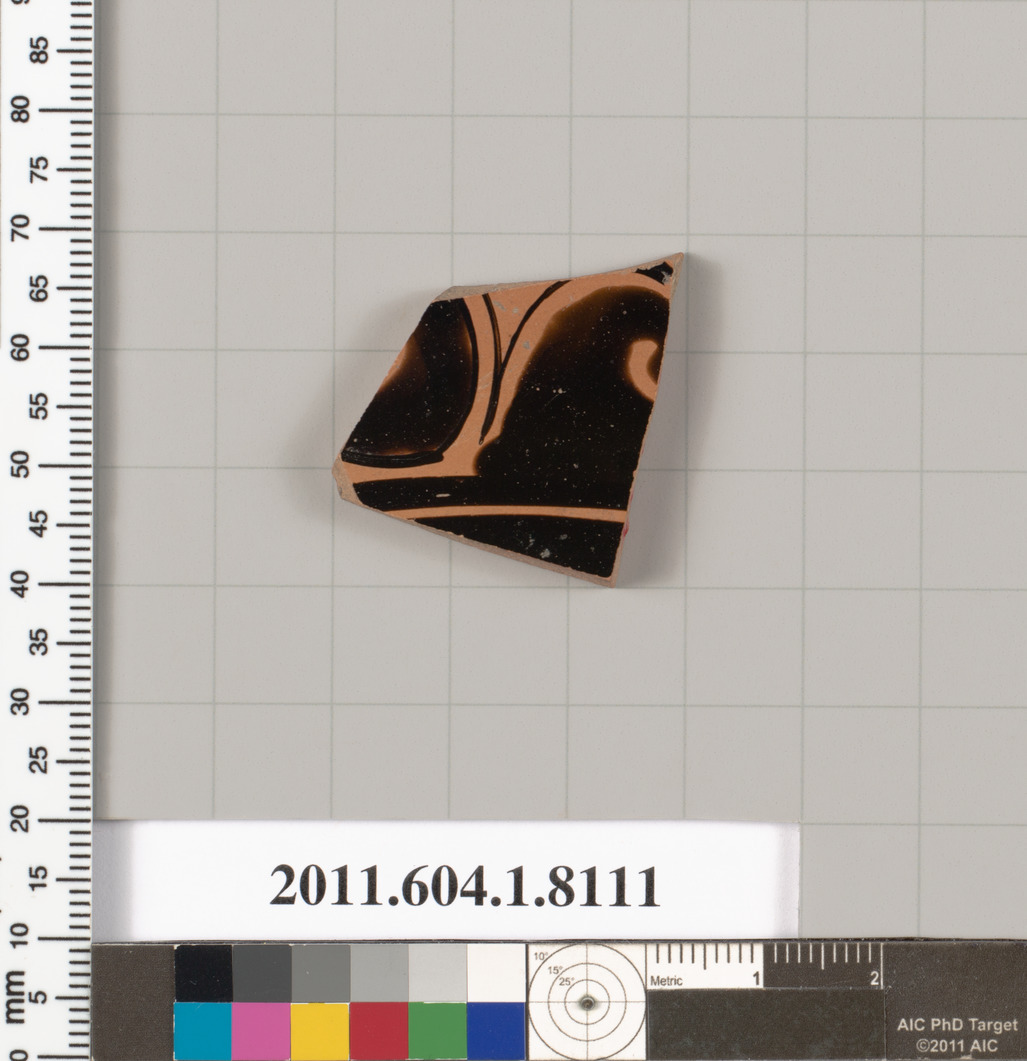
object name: kylix fragment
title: Terracotta fragment of a kylix (drinking cup)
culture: greek, attic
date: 534-468 BCE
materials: terracotta